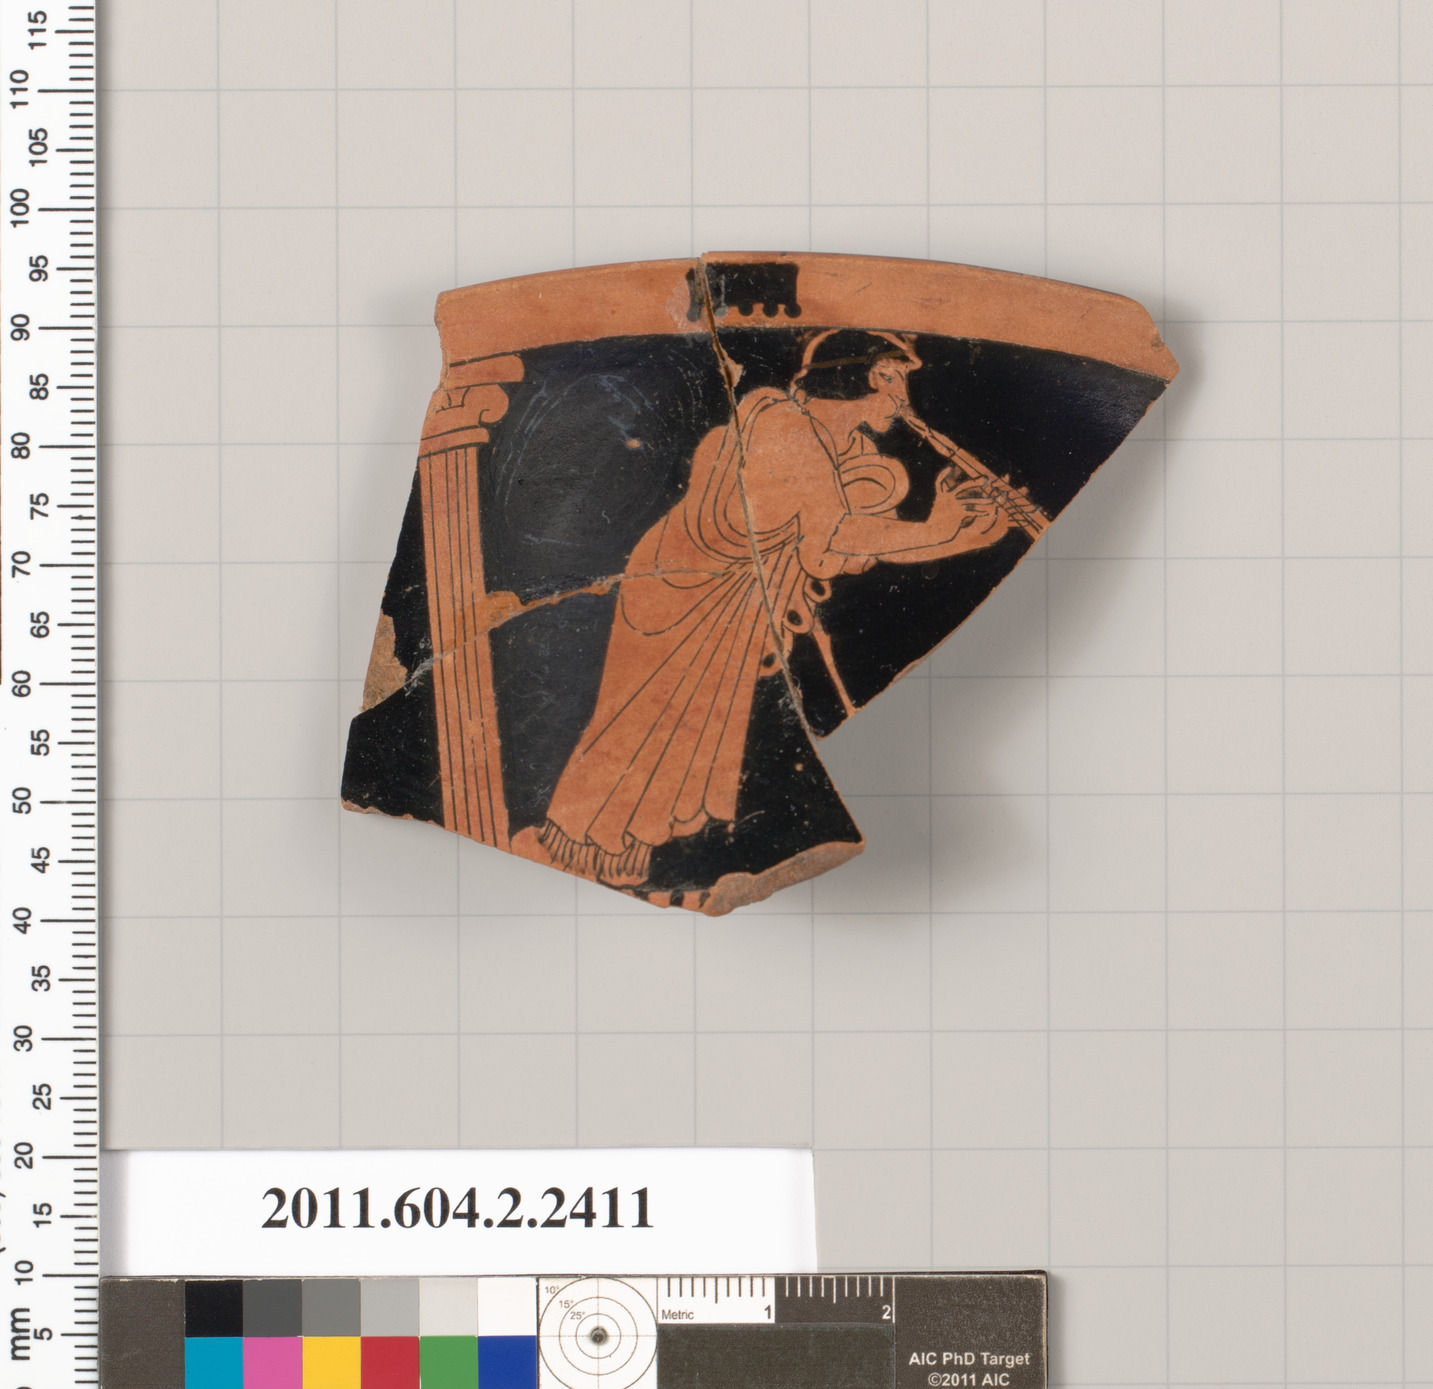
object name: rhyton fragment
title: Terracotta fragment of a rhyton (vase for libations or drinking)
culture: greek, attic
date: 470 BCE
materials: terracotta